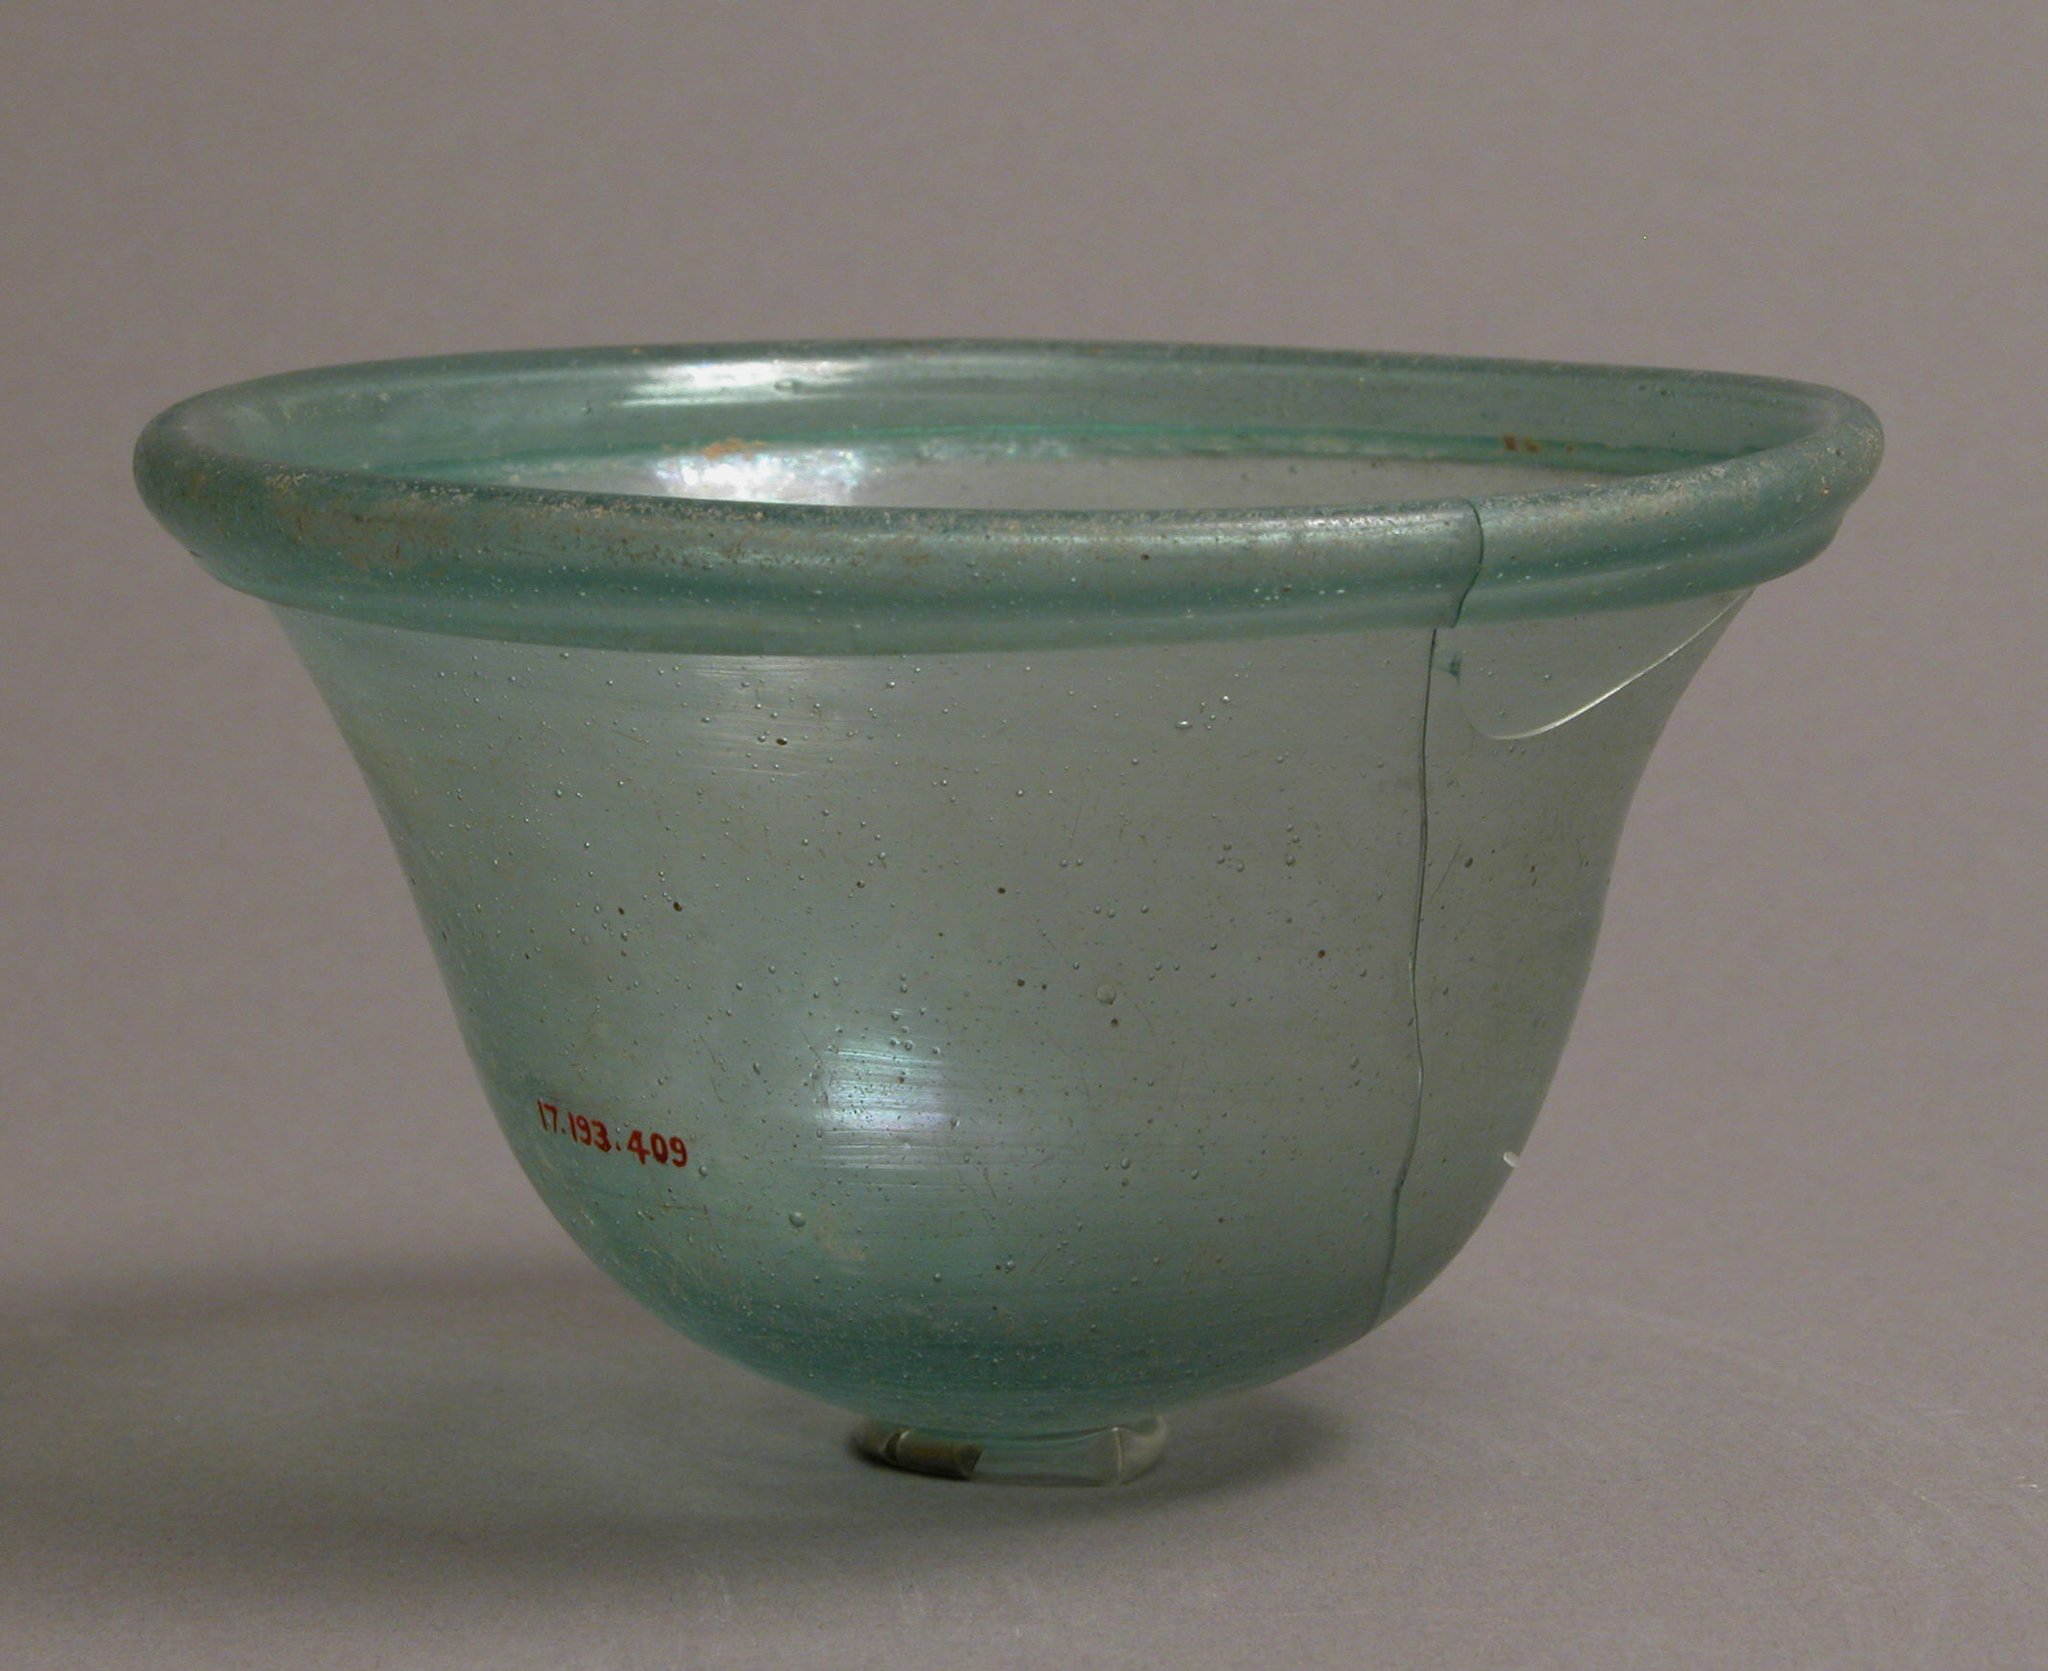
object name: cup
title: Palm Cup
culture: frankish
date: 601-800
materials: glass